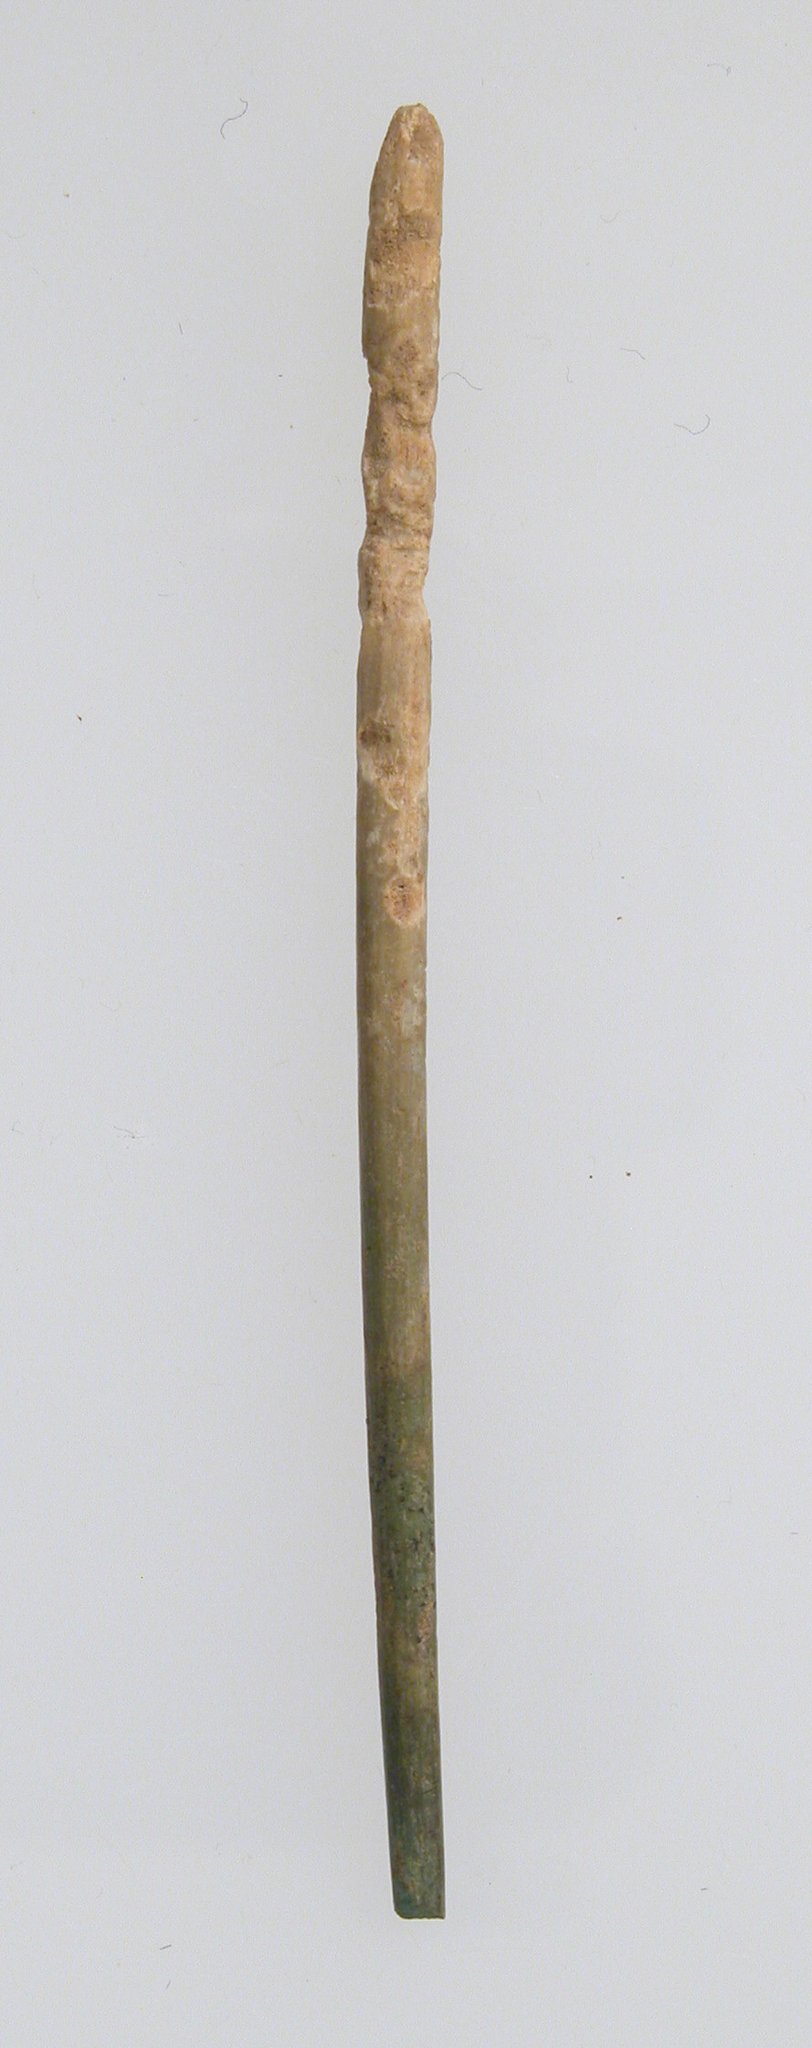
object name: hairpin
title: Upper Portion of Hairpin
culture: roman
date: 1-400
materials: bone